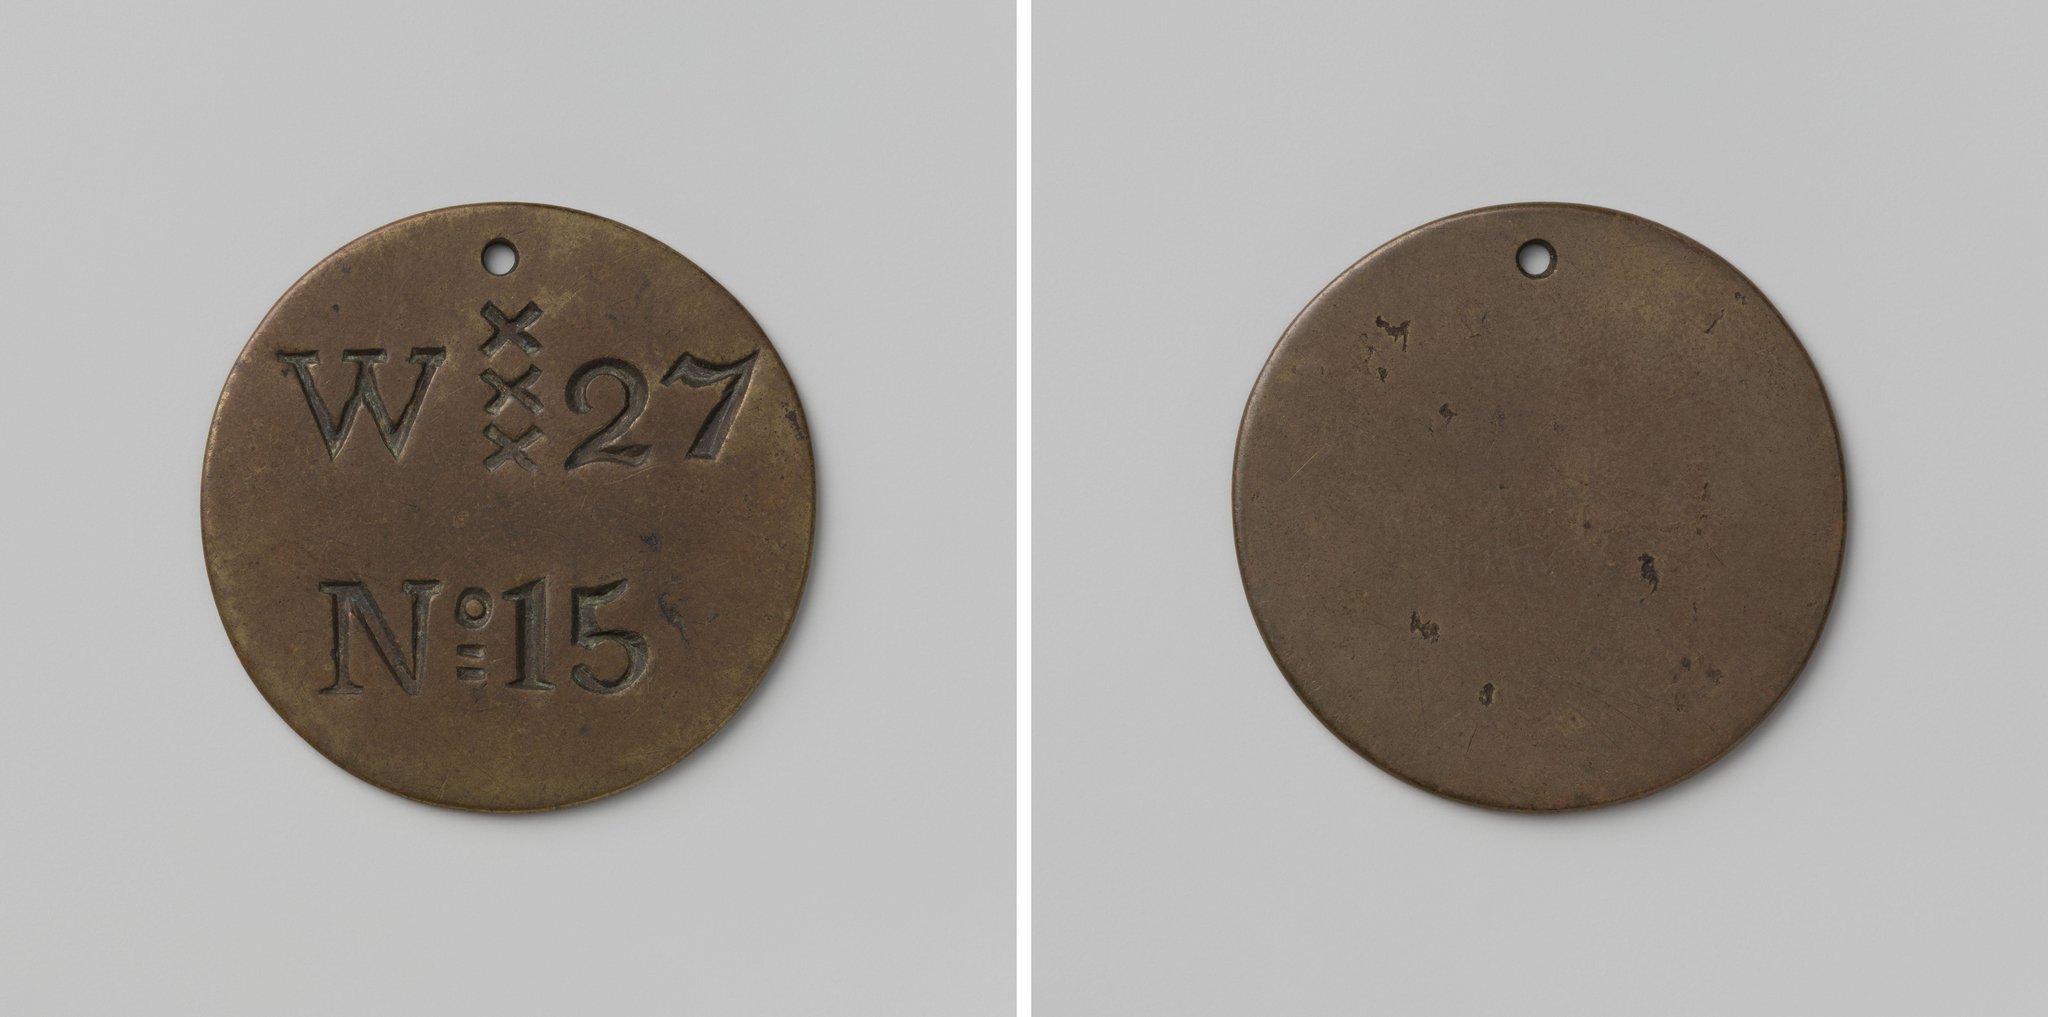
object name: fire engine medal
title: Amsterdam, brandspuitpenning van wijk 27 met no. 15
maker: Anonymous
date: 1831-1857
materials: brass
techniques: engraving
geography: amsterdam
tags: amsterdam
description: Eenzijdige messing penning met gat erin. Voorzijde: opschrift W 27, onderbroken door drie boven elkaar geplaatste kruisjes; daaronder: opschrift No. 15. Keerzijde: blanco